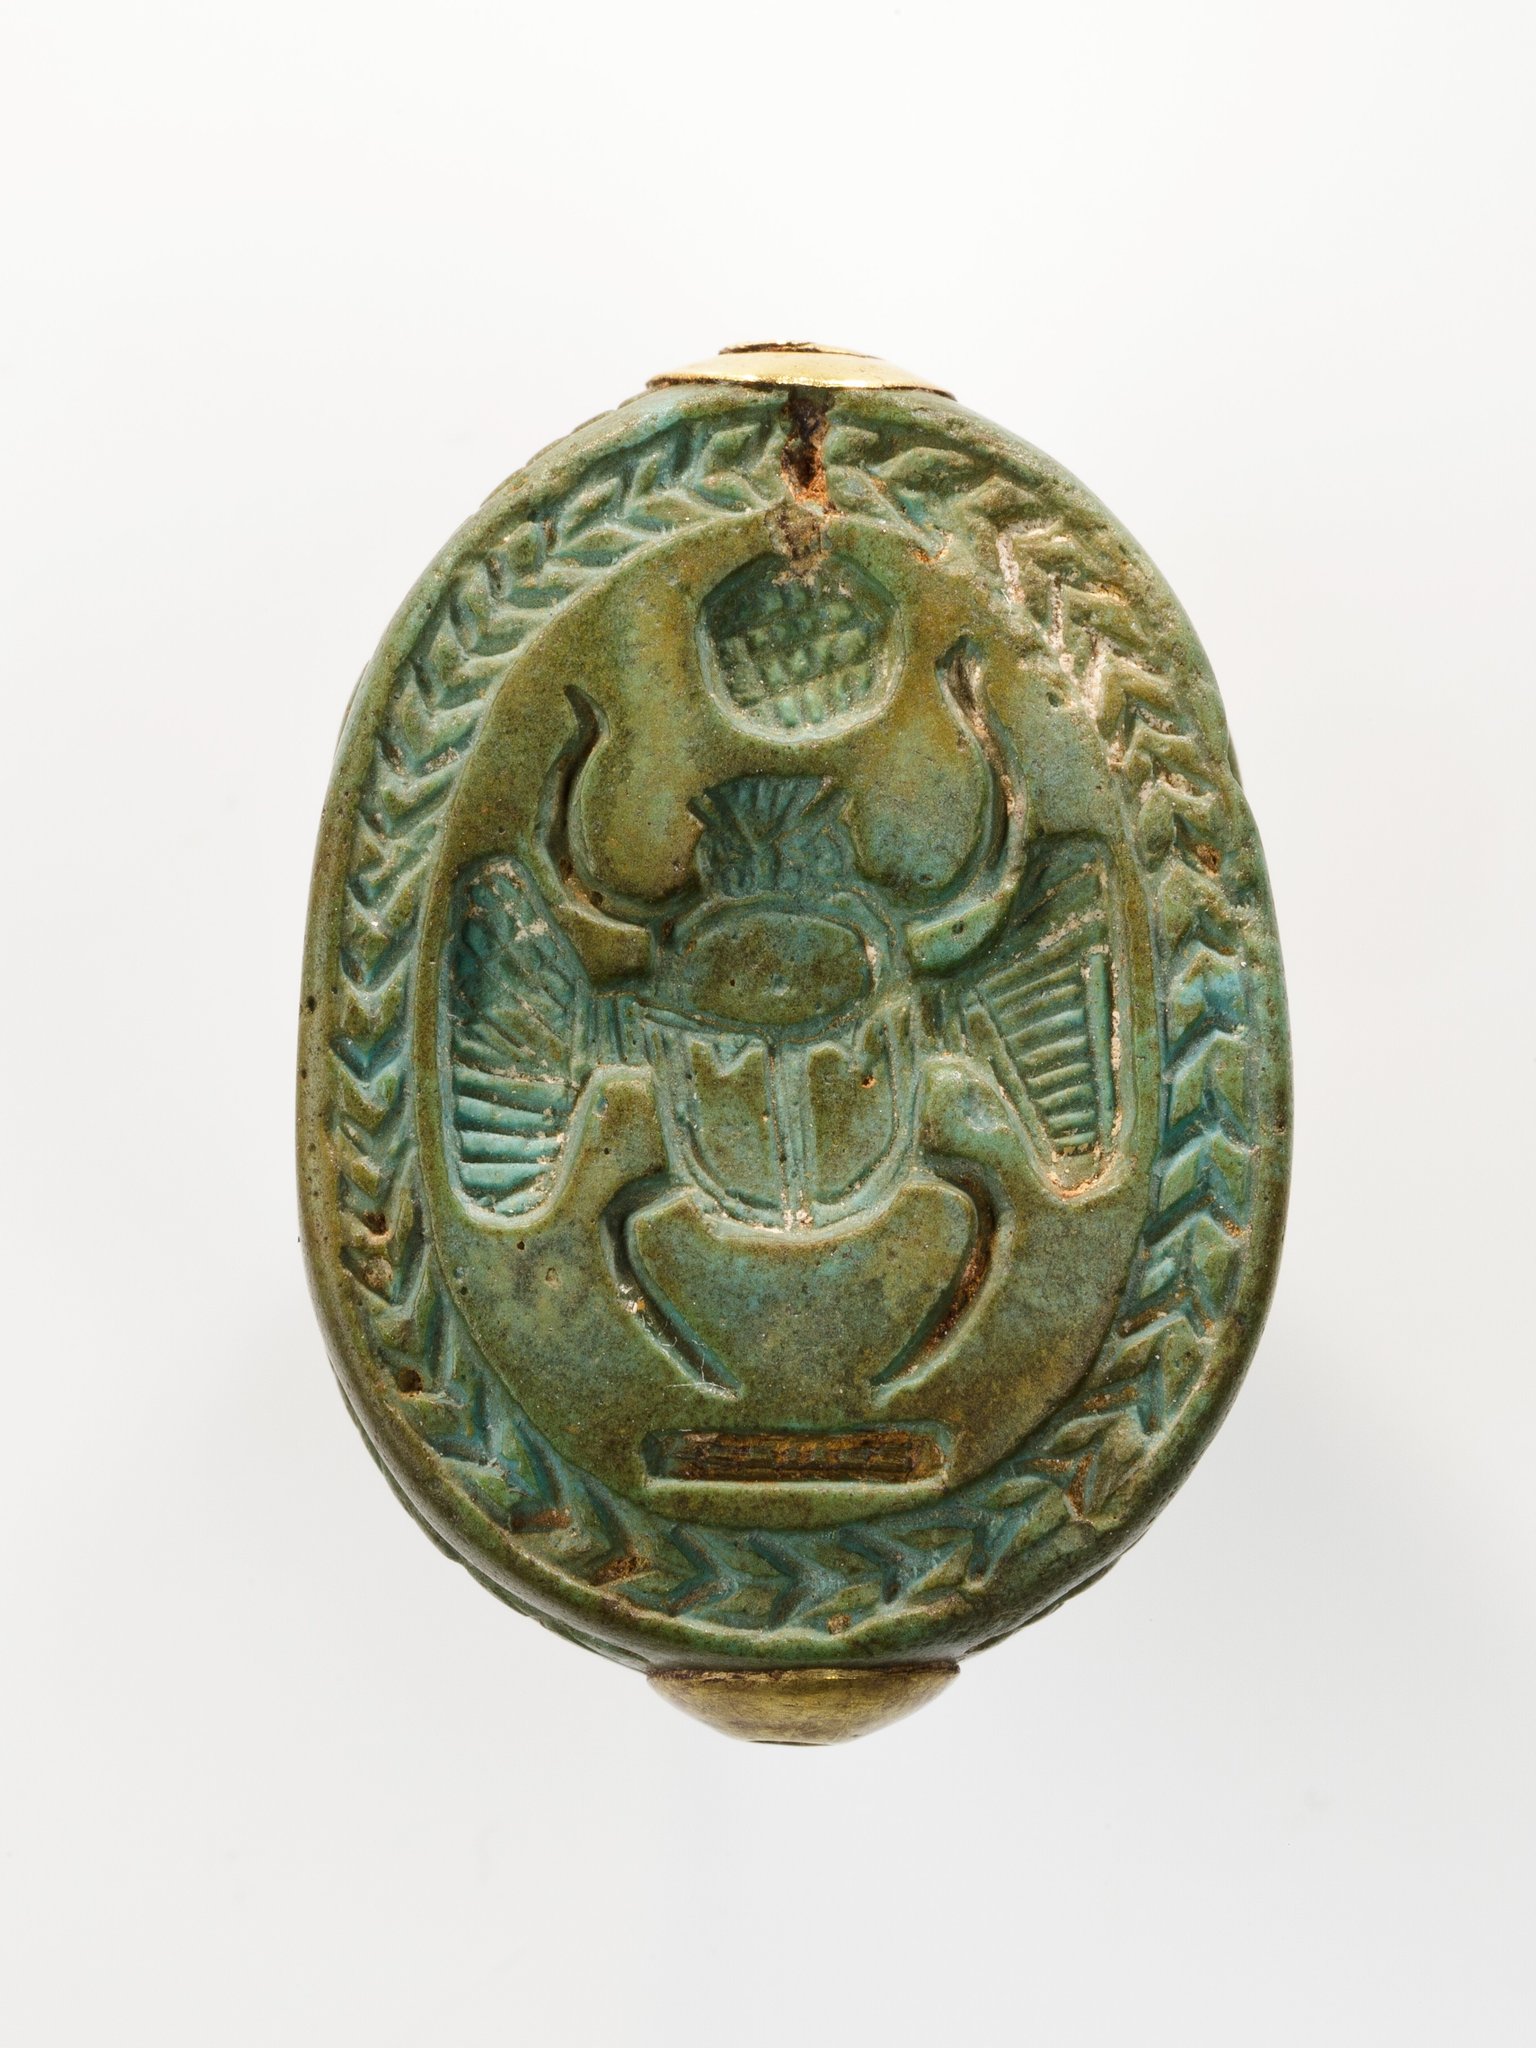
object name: scarab, setting, winged scarab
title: Scarab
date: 1550-1479 BCE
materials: gold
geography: egypt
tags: scarabs